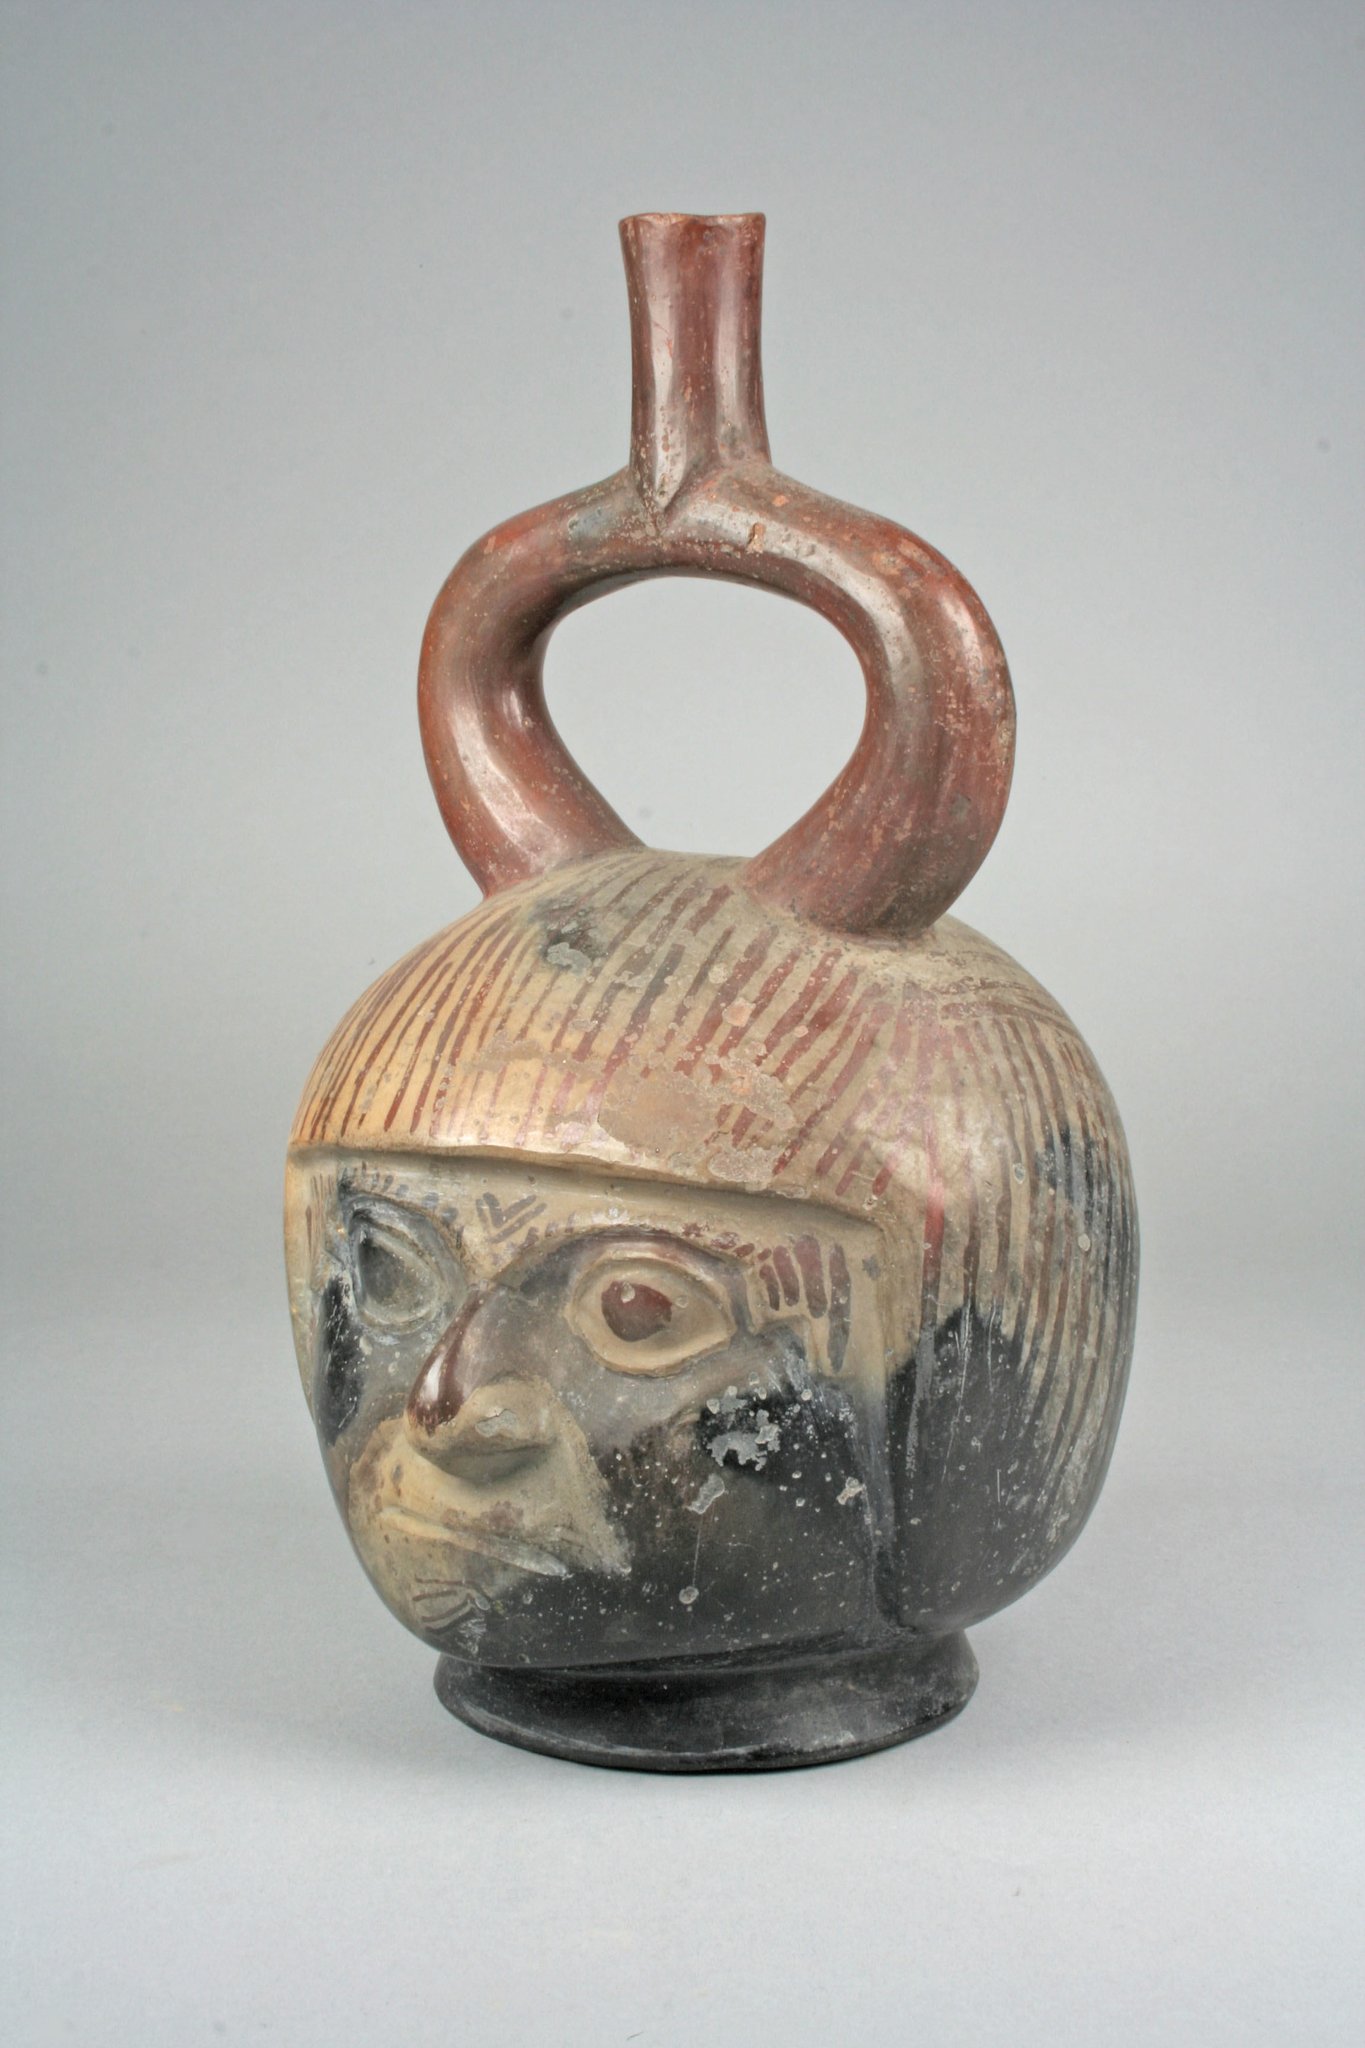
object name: bottle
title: Stirrup Spout Bottle with Portrait Head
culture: moche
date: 1-400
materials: ceramic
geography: peru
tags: heads,portraits